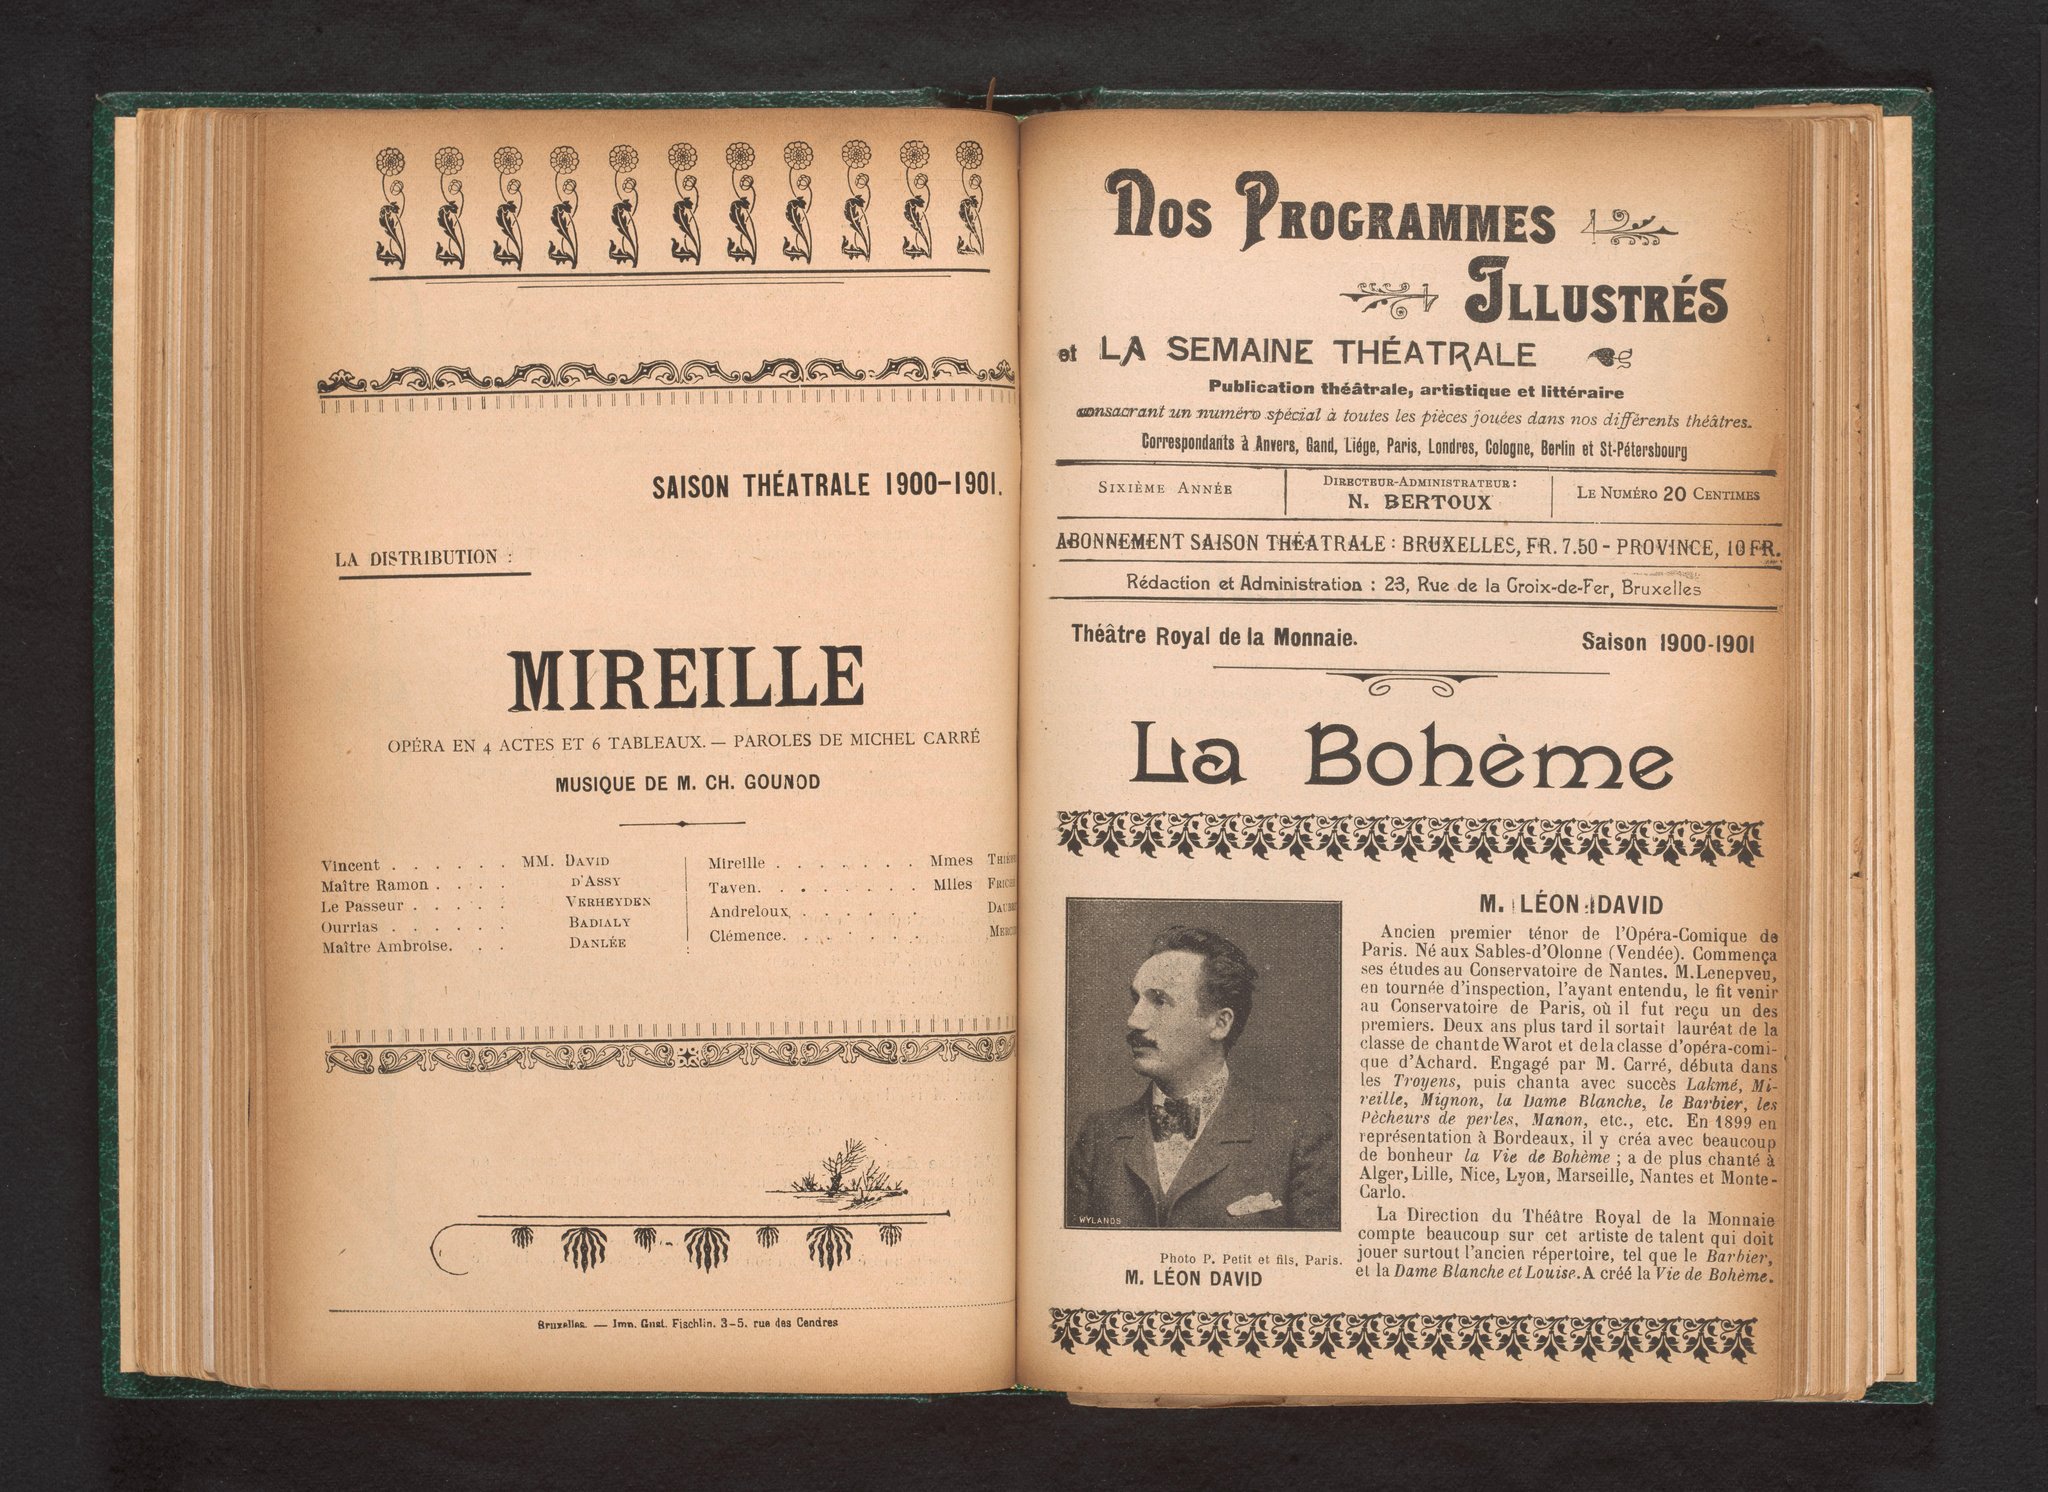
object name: photomechanical print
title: Portret van Léon David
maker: Anonymous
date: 1895-1900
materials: paper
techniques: autotype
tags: adult woman, historical persons